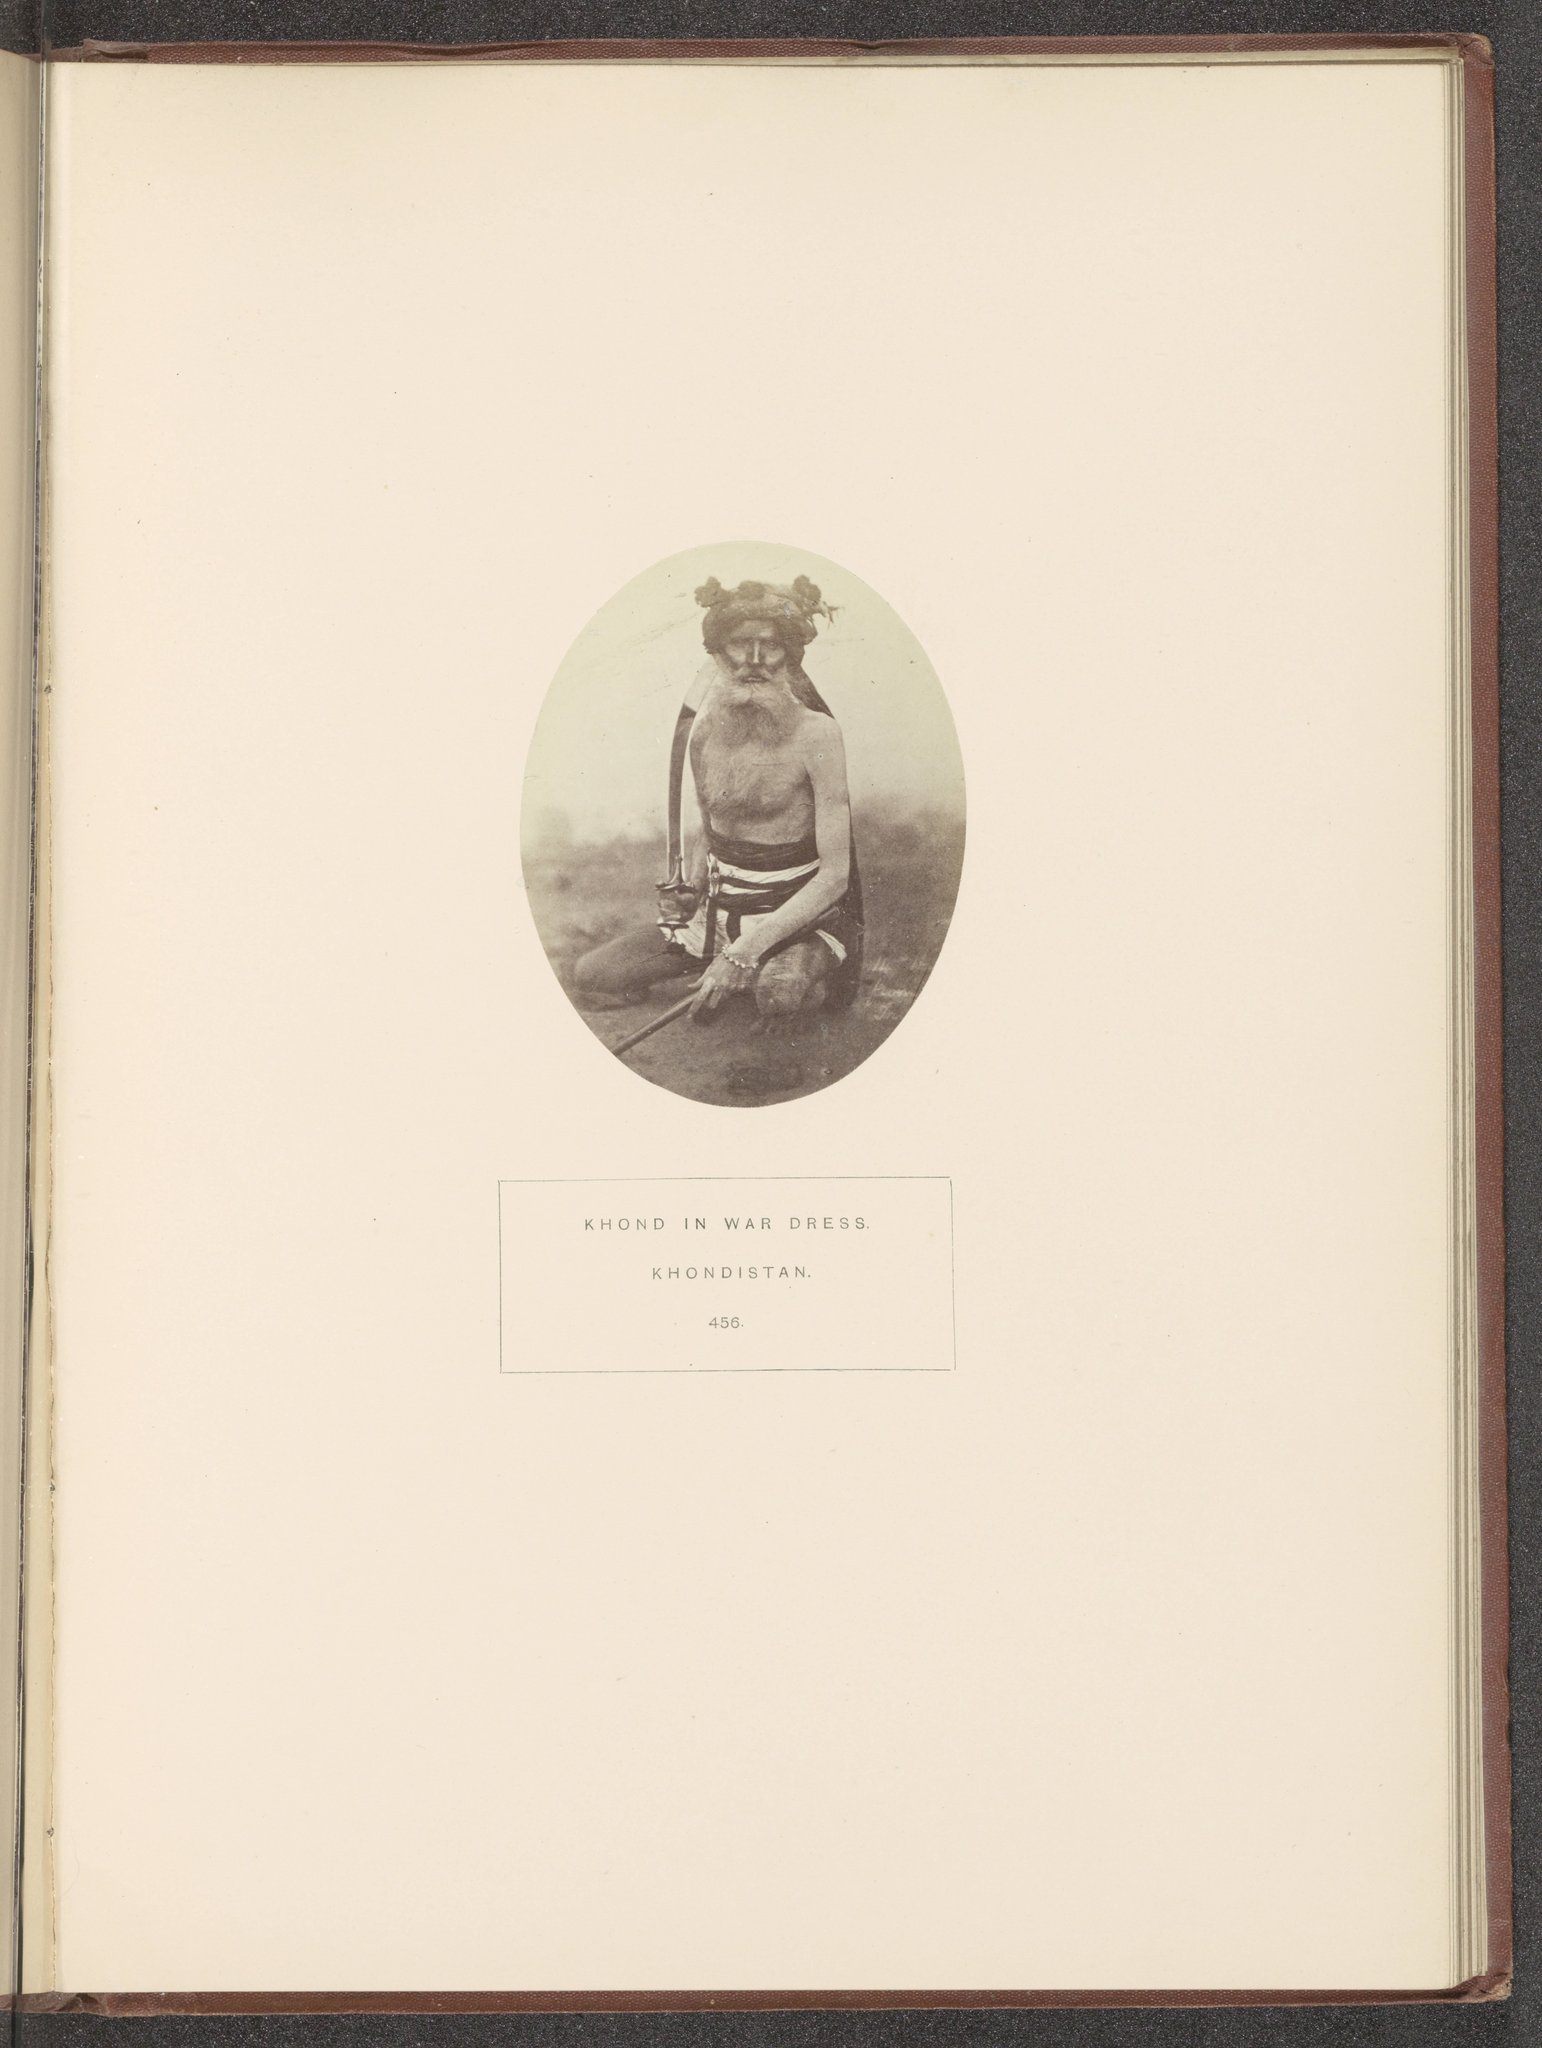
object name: photograph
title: Portrait of an unknown man in his warrior clothes from the Khond tribe in Odisha, India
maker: charles philip yorke triscott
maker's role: fotograaf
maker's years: 1824-1880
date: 1865-1875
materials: photographic support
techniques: albumen print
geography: odisha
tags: human races; peoples; nationalities, clothes, costume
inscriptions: inscription: ‘KHOND IN WAR DRESS./ KHONDISTAN.’, number: ‘456.’